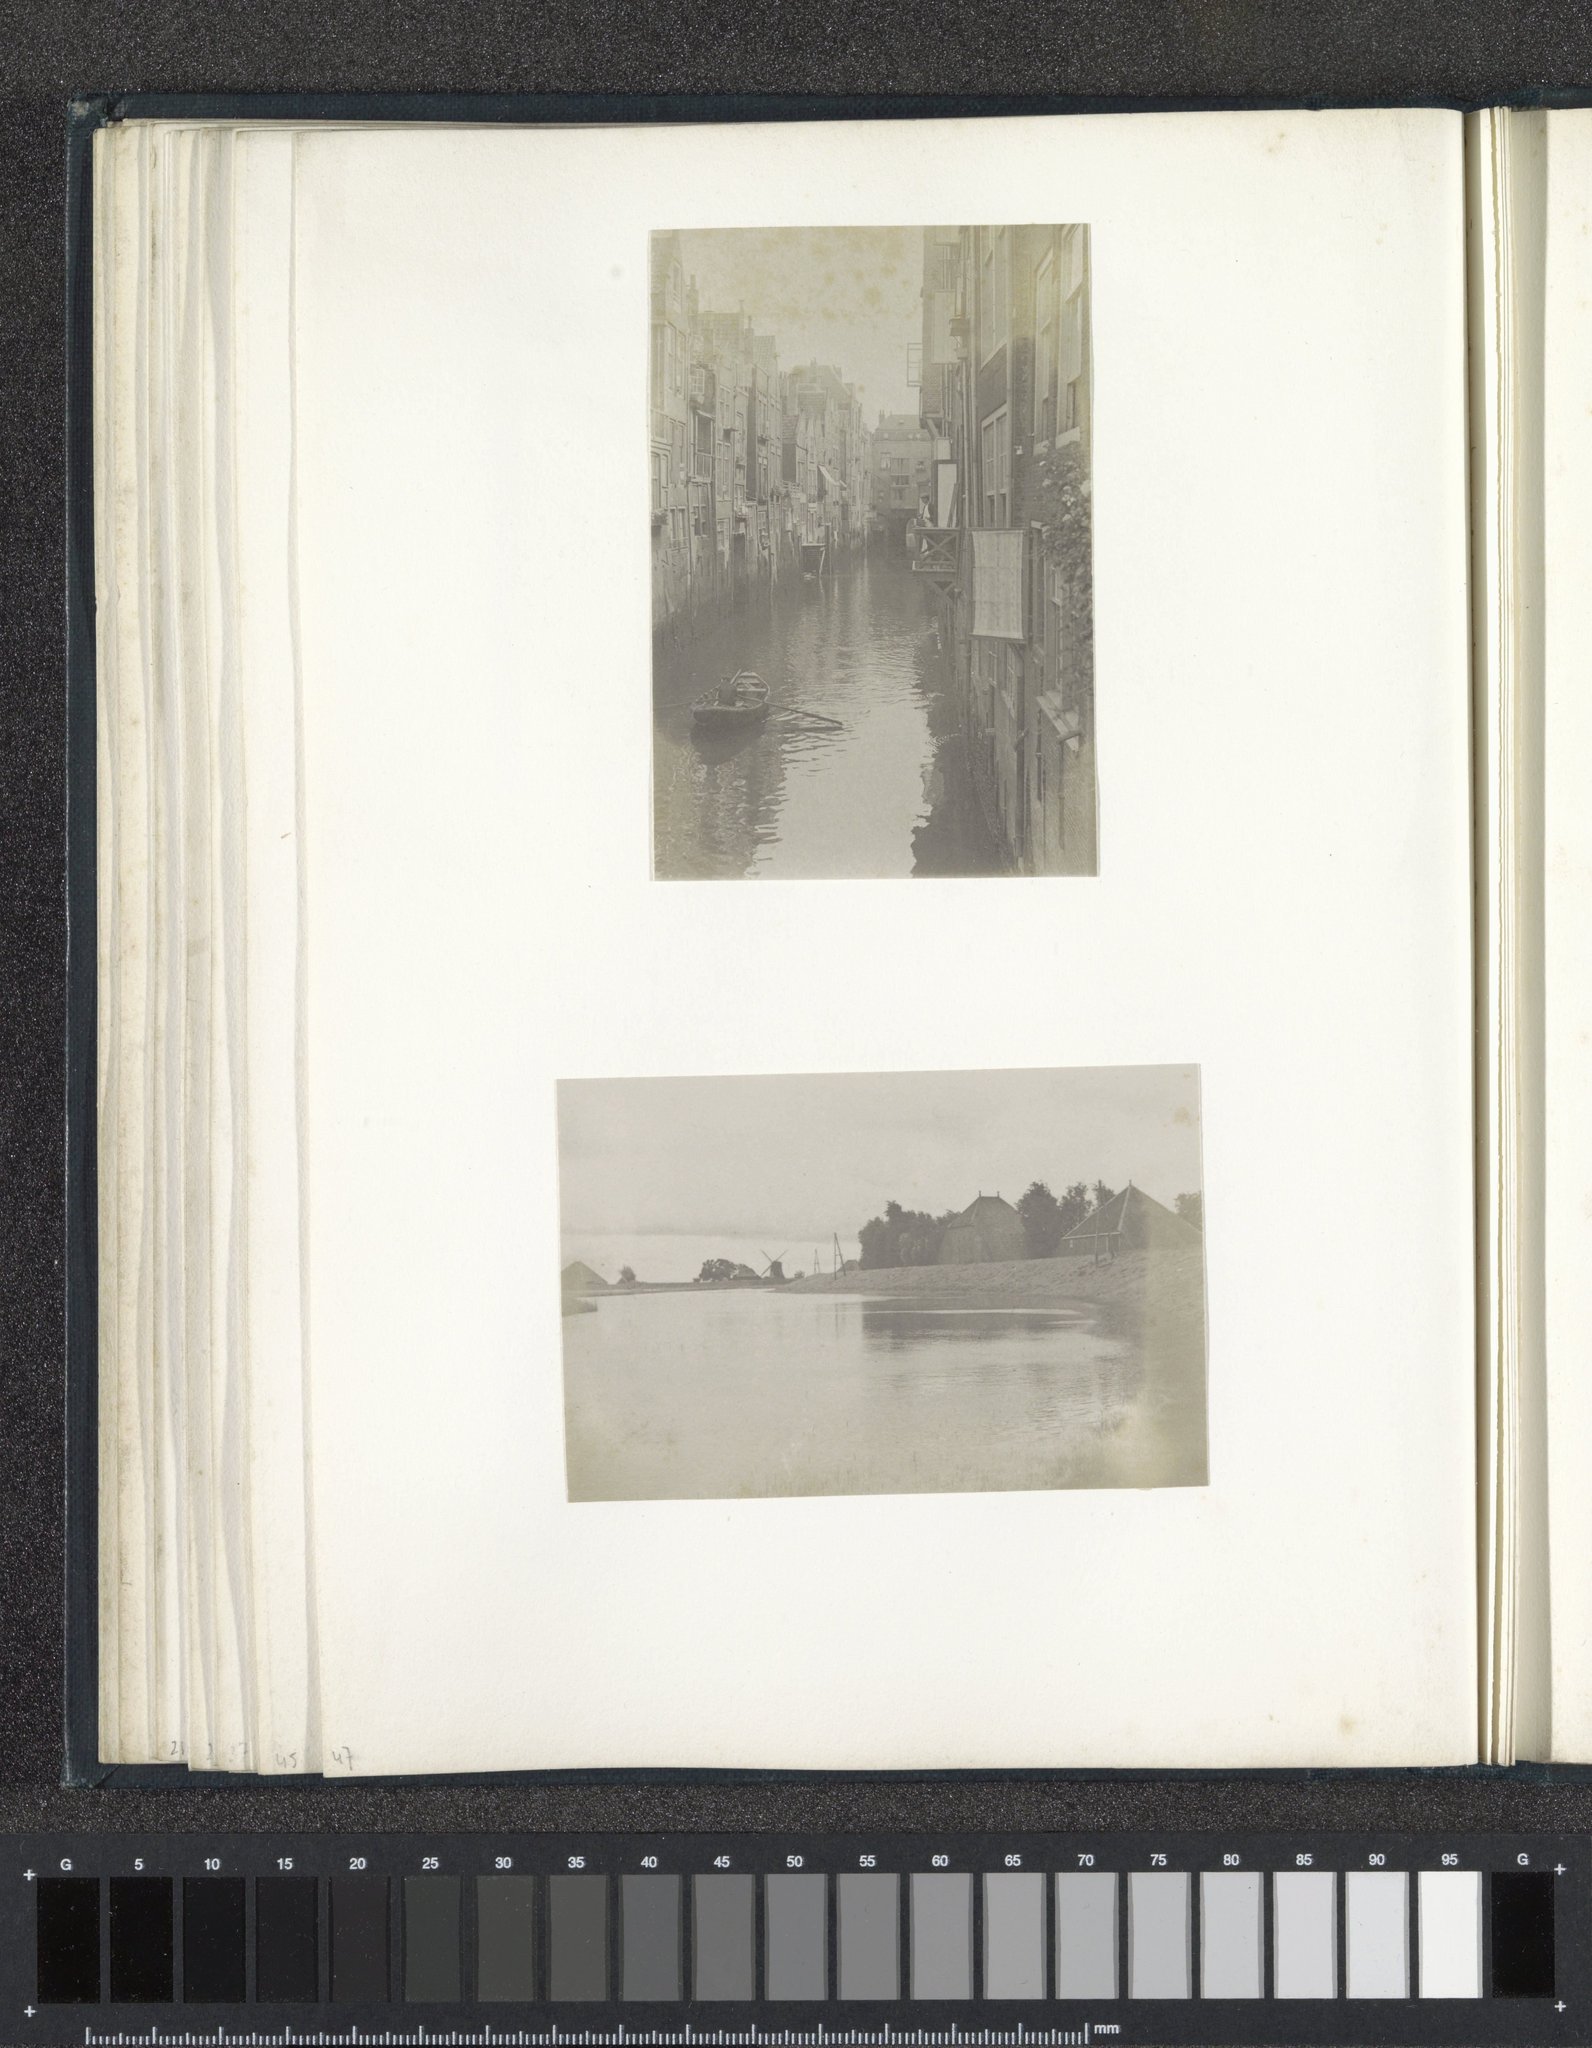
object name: photograph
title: Boerderijen aan een water, vermoedelijk in Noord-Holland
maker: george hidderley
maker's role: fotograaf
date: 1900-1910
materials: paper, photographic support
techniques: gelatin silver print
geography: north holland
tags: lake, farm (building)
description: Onderdeel van fotoalbum met opnames van Volendam, Dordrecht, Gorinchem en Woudrichem.